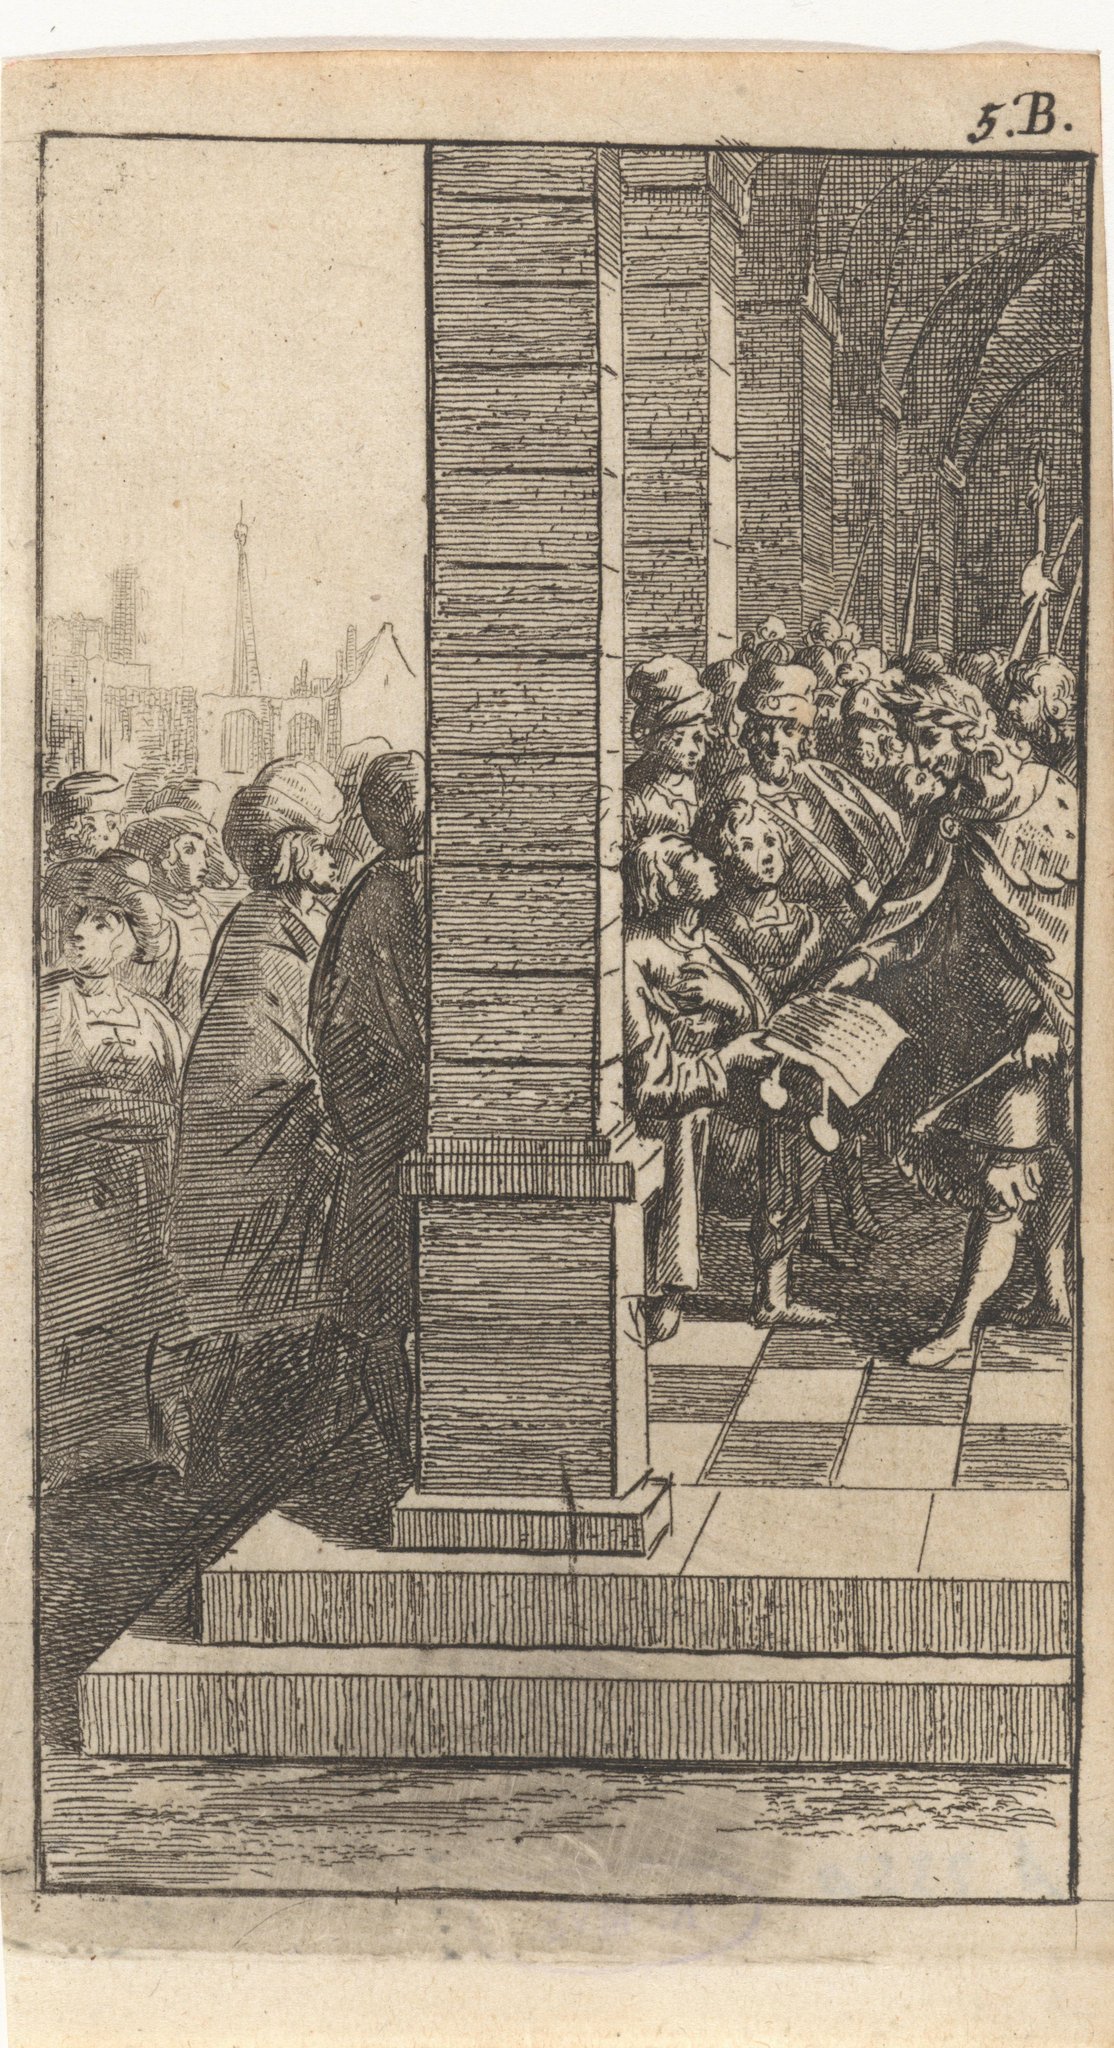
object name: book illustration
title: Kinderen bieden keizer Augustus(?) een brief met zegels aan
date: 1667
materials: paper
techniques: etching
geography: amsterdam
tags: boy (child between toddler and youth), private soldier, emperor, letter, envelope, front steps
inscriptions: collector's mark: Lugt 2228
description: In een portico bieden twee kinderen keizer Augustus(?) een brief met zegels aan. De keizer draagt een met hermelijn afgezette mantel, een lauwerkrans en een scepter. Bij hem staan enkele hooggeplaatste personen en soldaten. Links in de verte enkele gebouwen. Rechtsboven: 5. B.